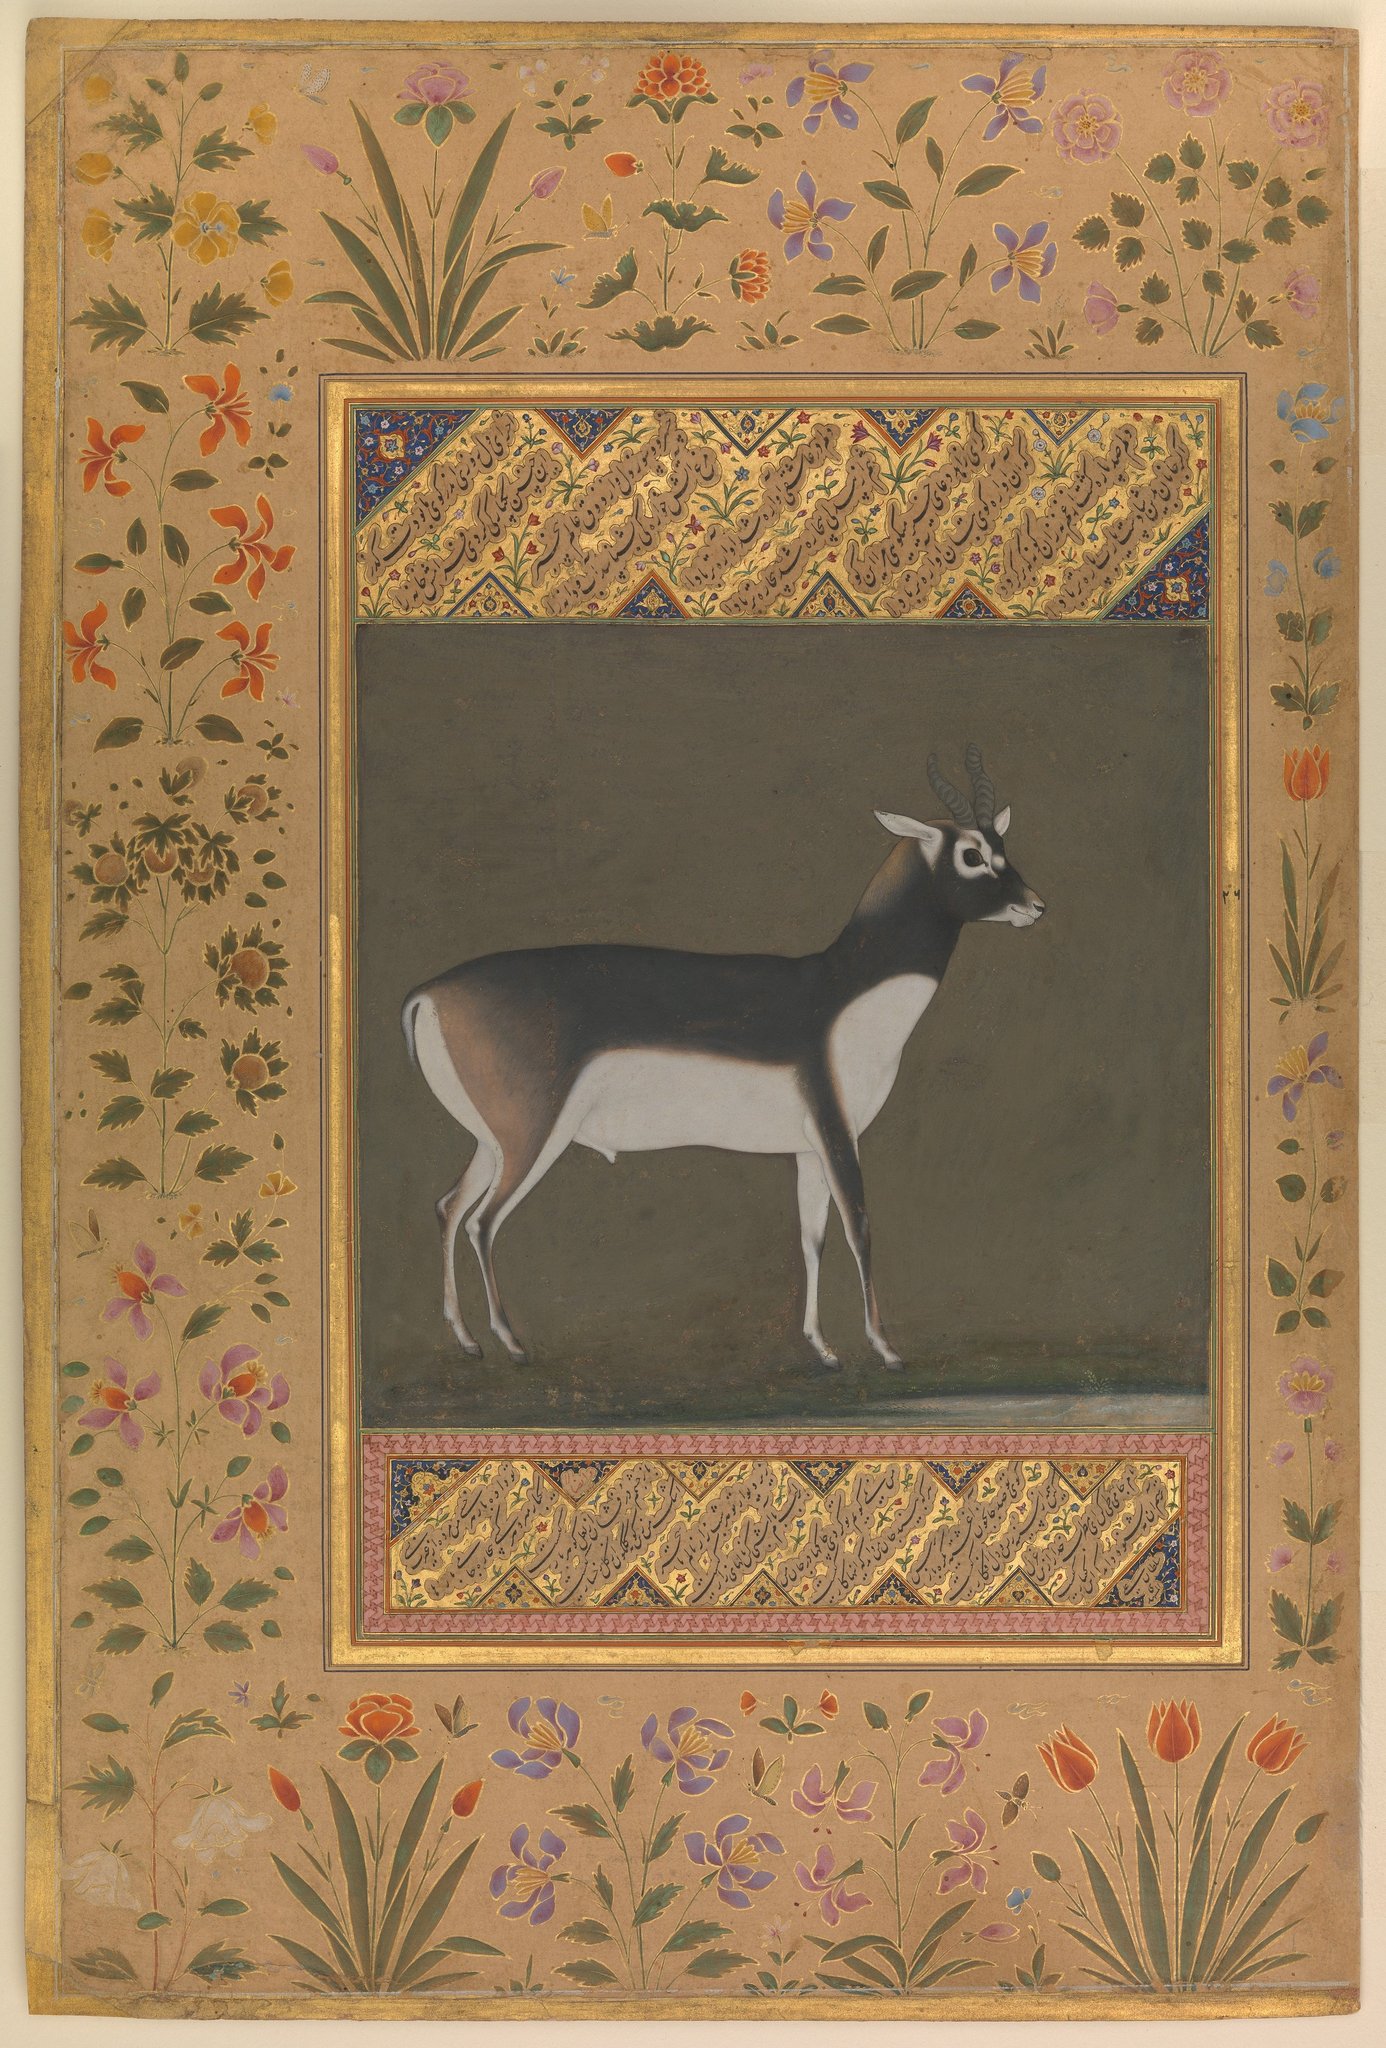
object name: album leaf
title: "Black Buck", Folio from the Shah Jahan Album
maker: manohar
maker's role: artist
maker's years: 1577-1624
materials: gold, ink, paper, watercolor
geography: india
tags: animals,flowers,leaves